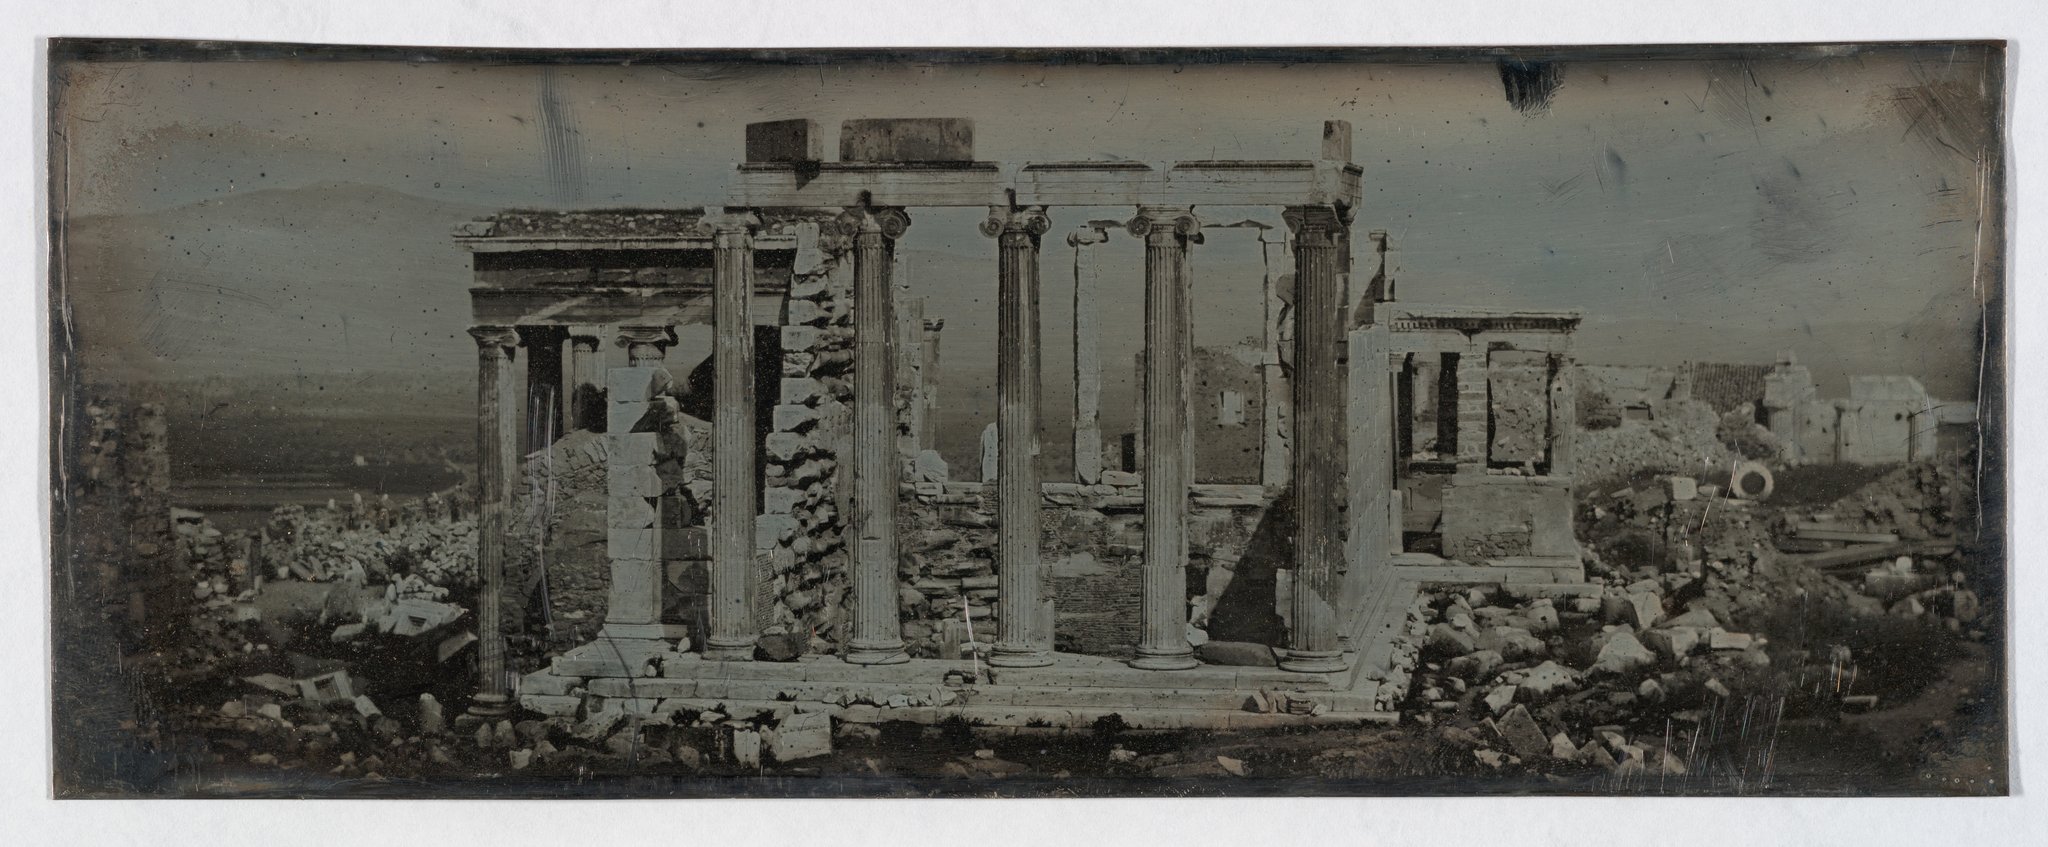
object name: photograph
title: Erechtheion, Athens (62. Athènes. 1842. T. de Minerve Poliade.)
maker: joseph-philibert girault de prangey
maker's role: artist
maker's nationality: french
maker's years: 1804-1892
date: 1842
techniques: daguerreotype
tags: architecture,ruins